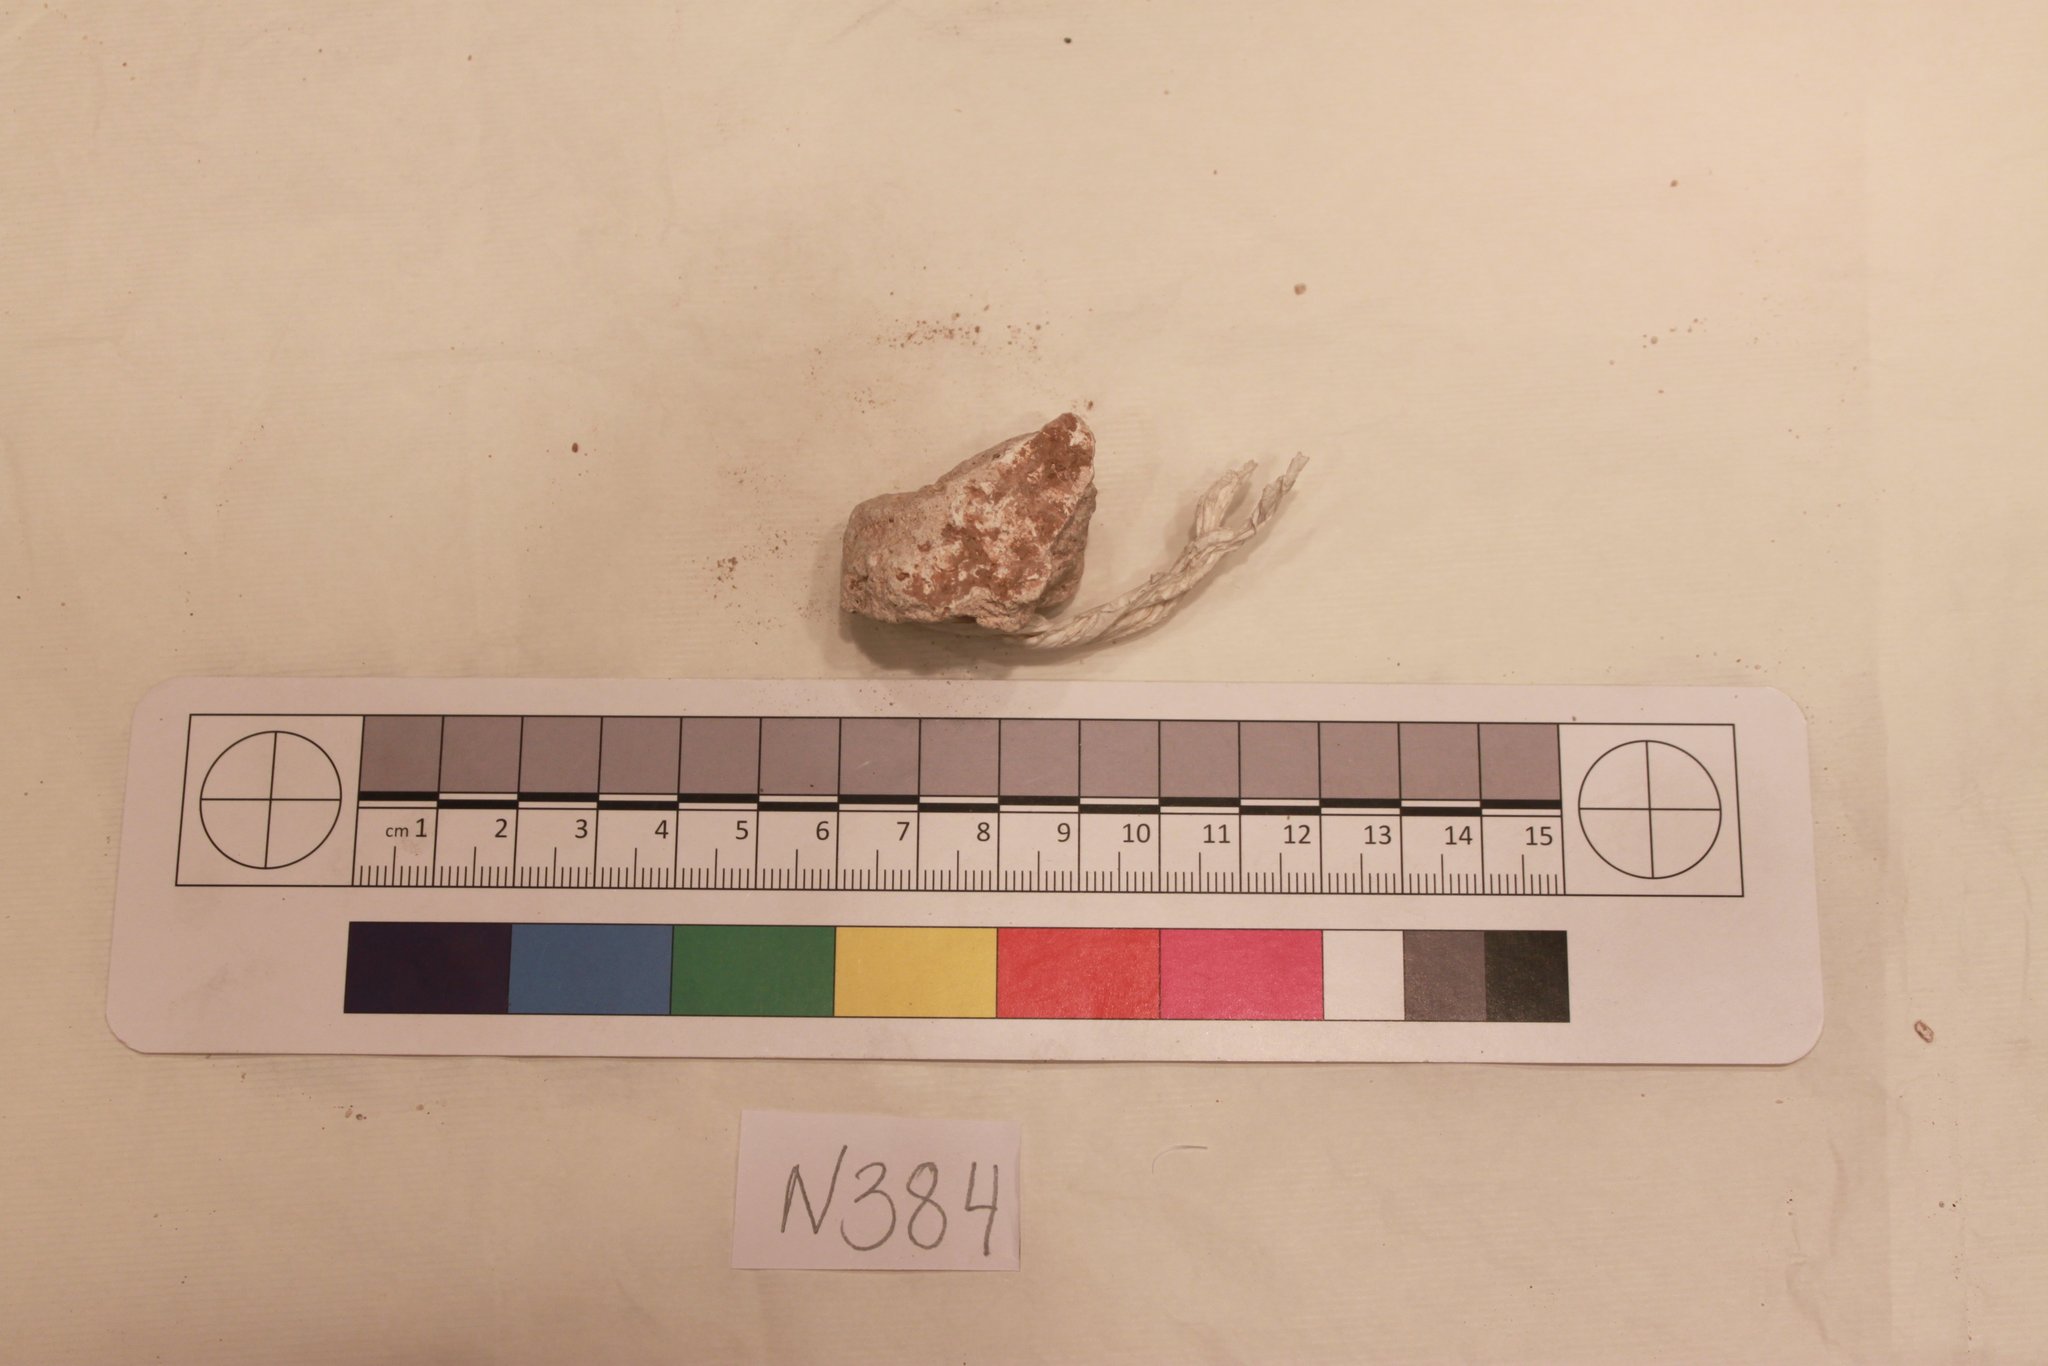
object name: fragment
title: Stucco Fragment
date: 701-1200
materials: plaster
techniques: carving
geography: iran